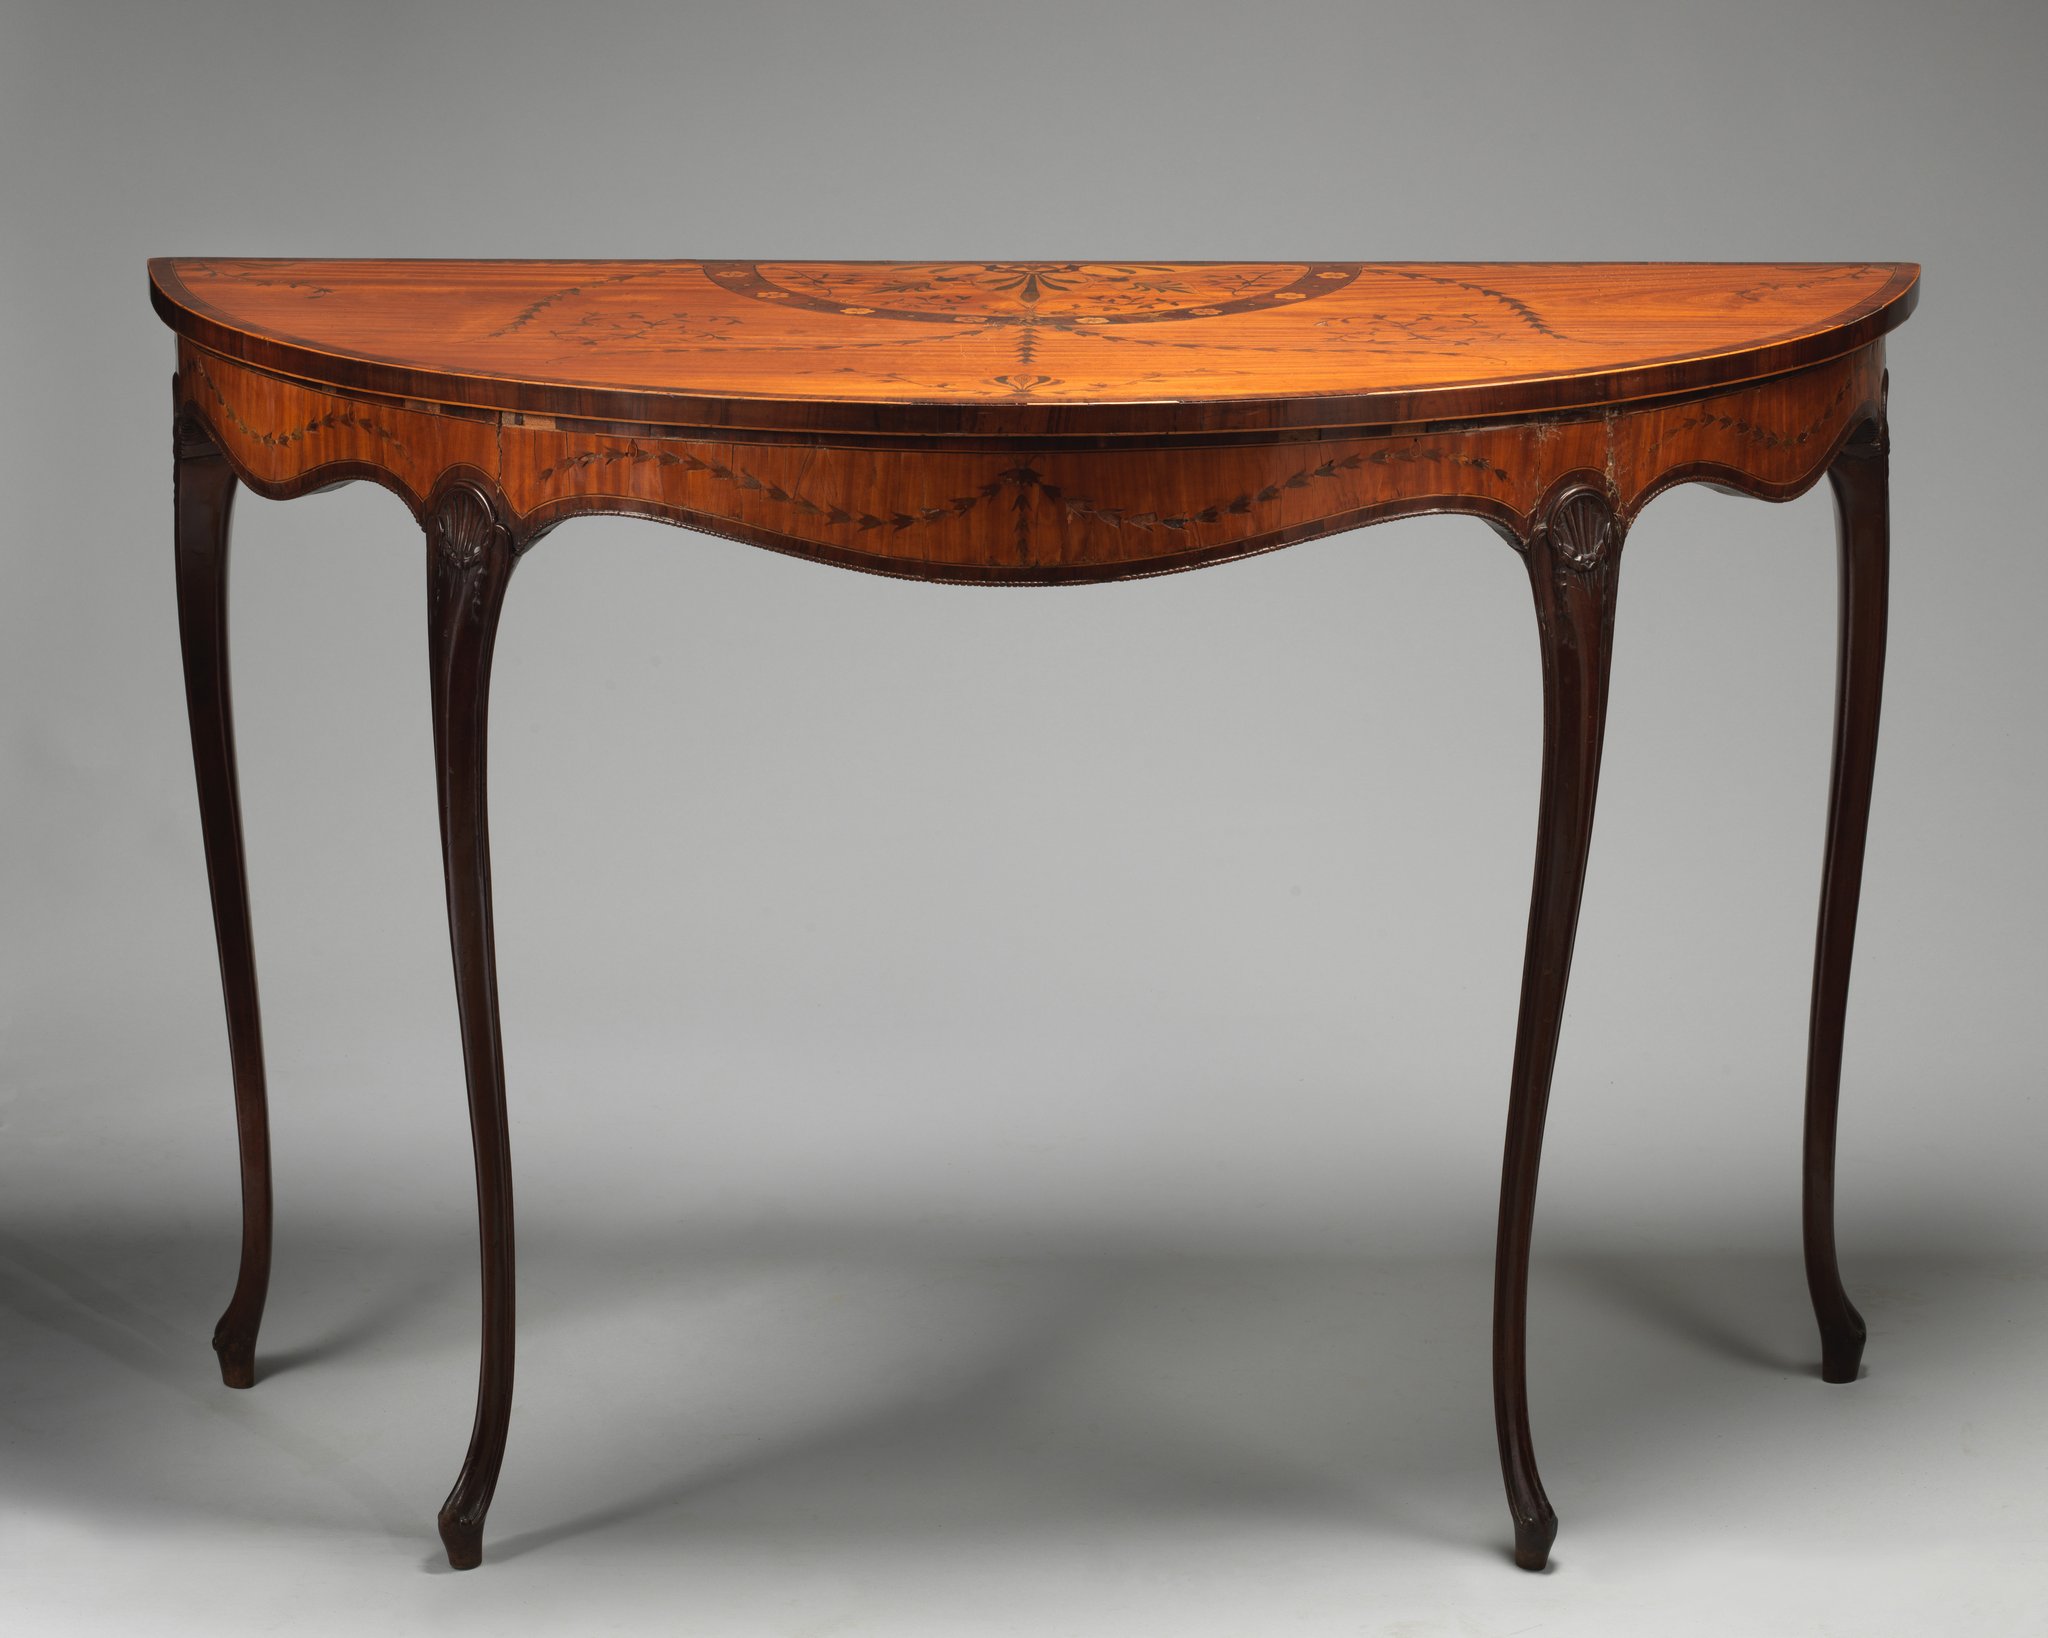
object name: side table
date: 1788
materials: wood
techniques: veneering